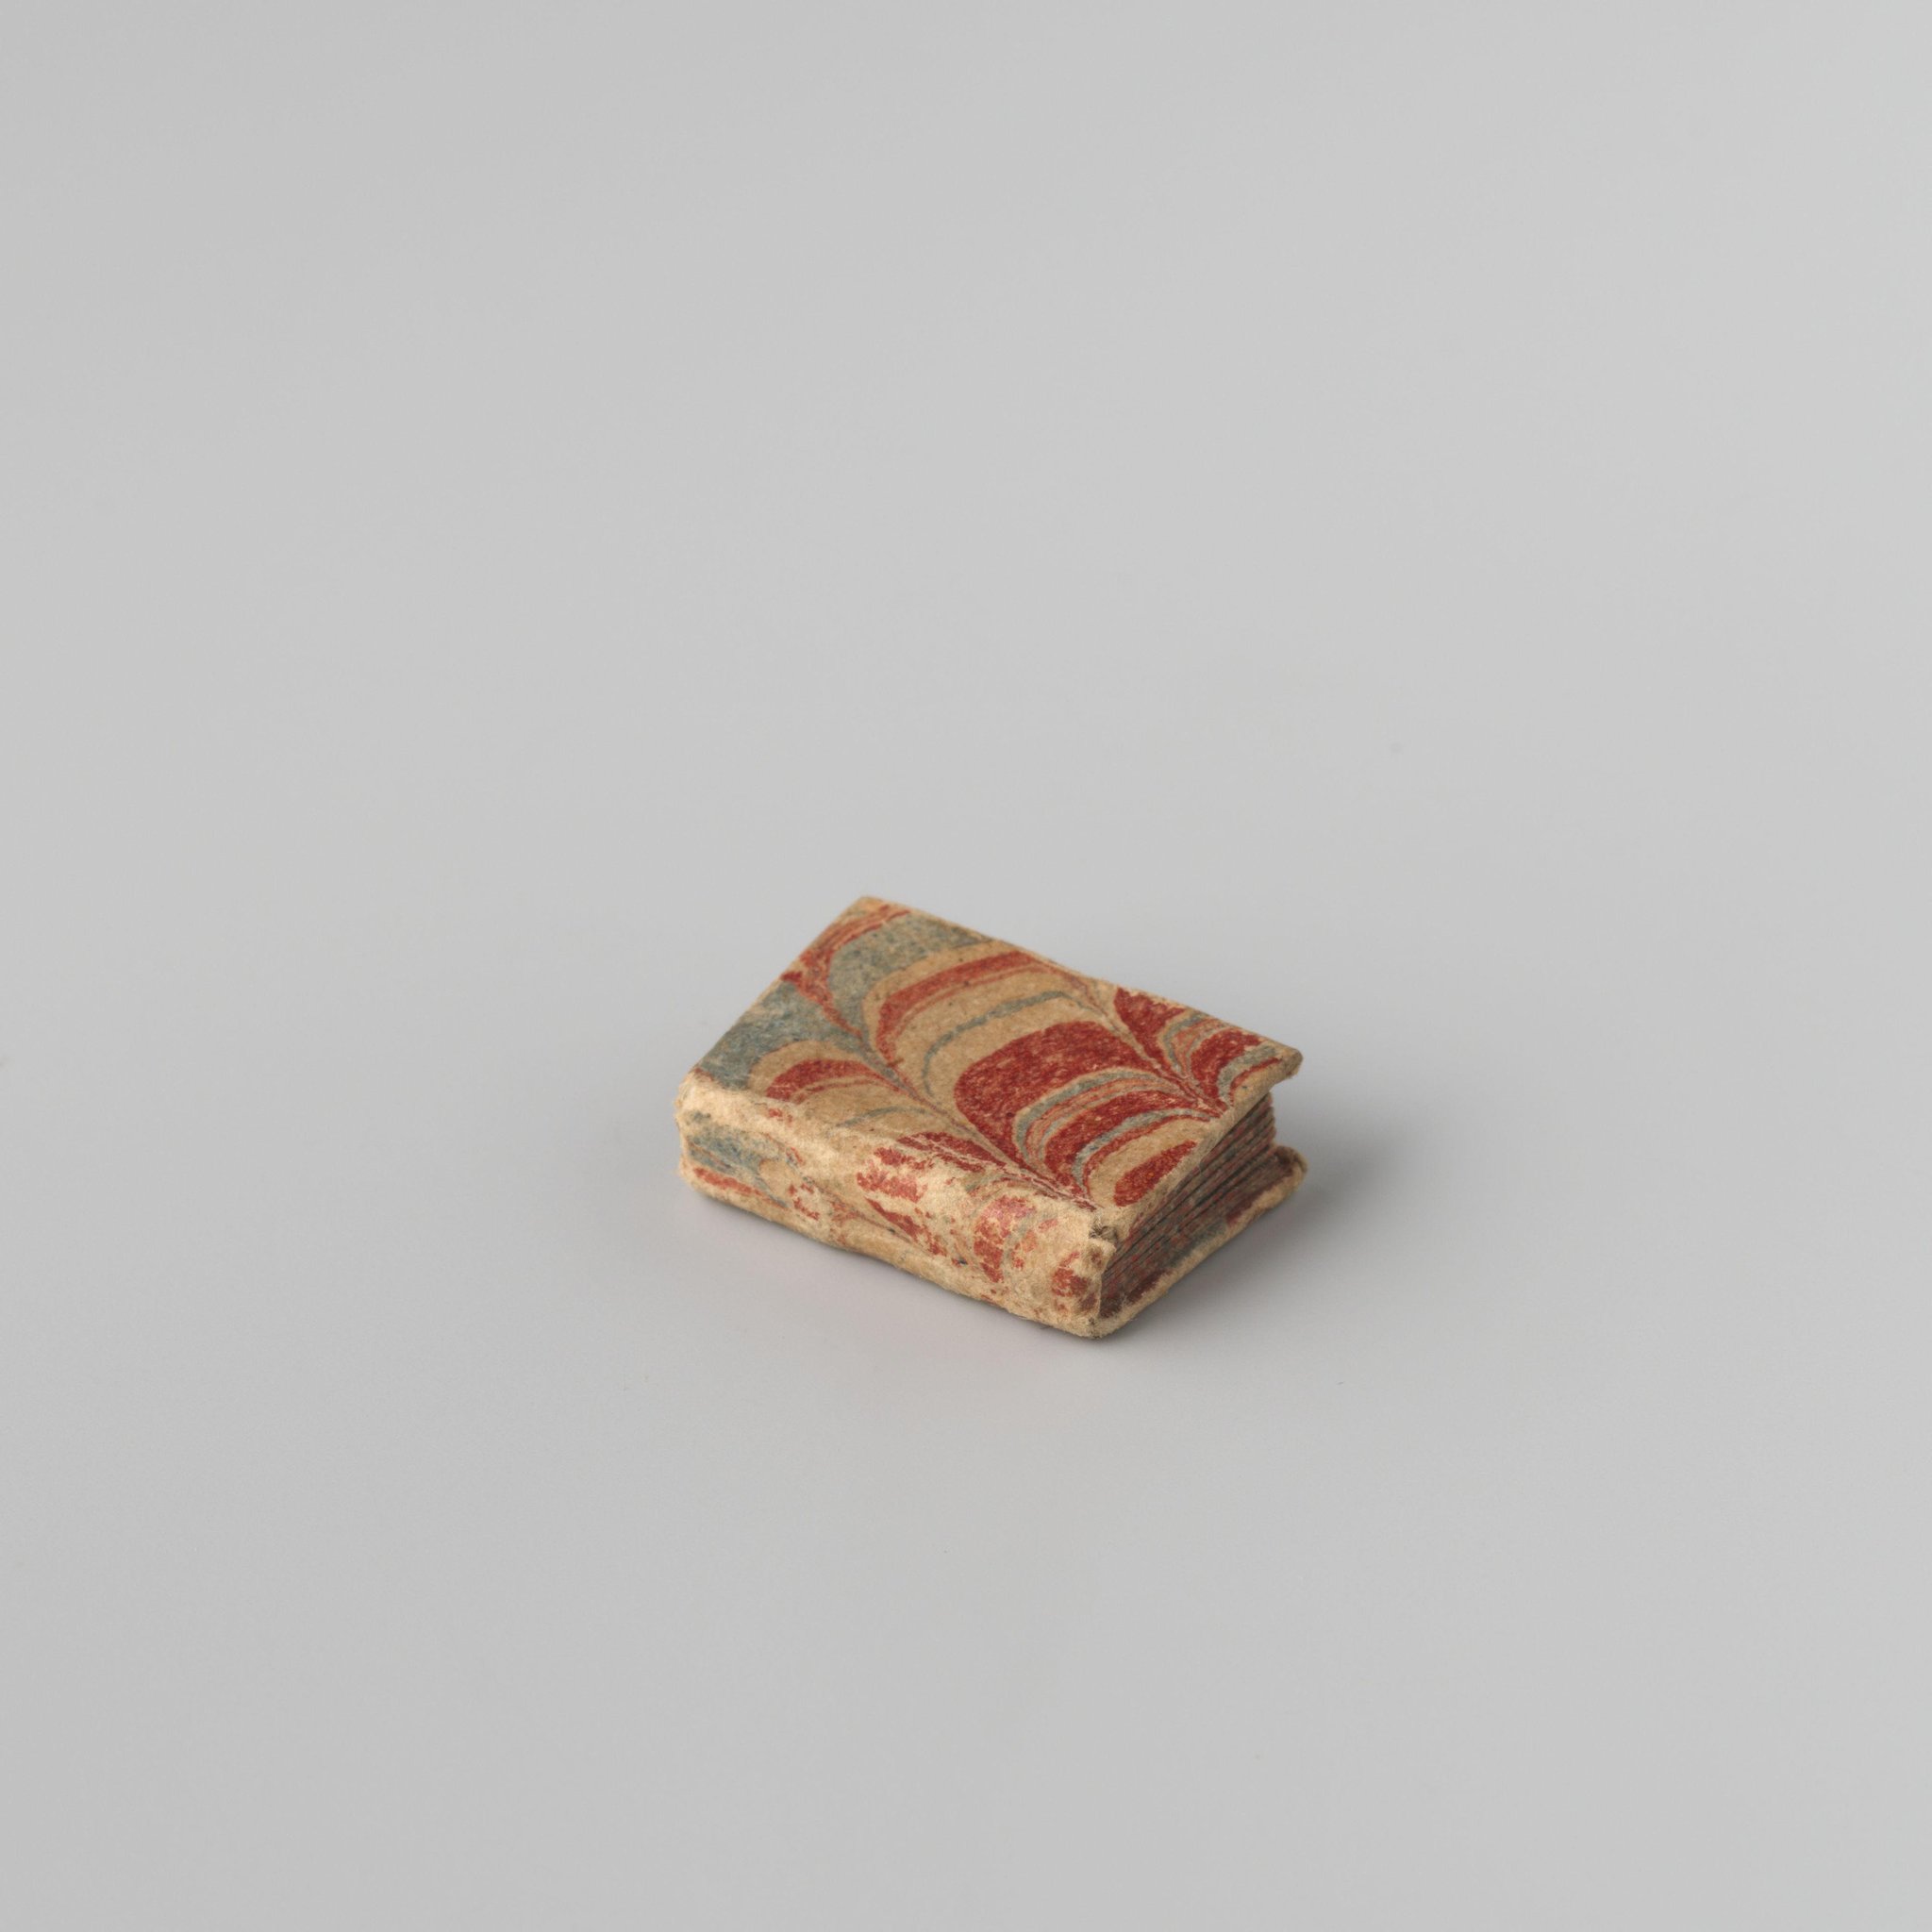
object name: miniature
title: Boek met figuren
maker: Anonymous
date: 1690-1710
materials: paper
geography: amsterdam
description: Boek met figuren. Ingebonden in gemarmerd papier.